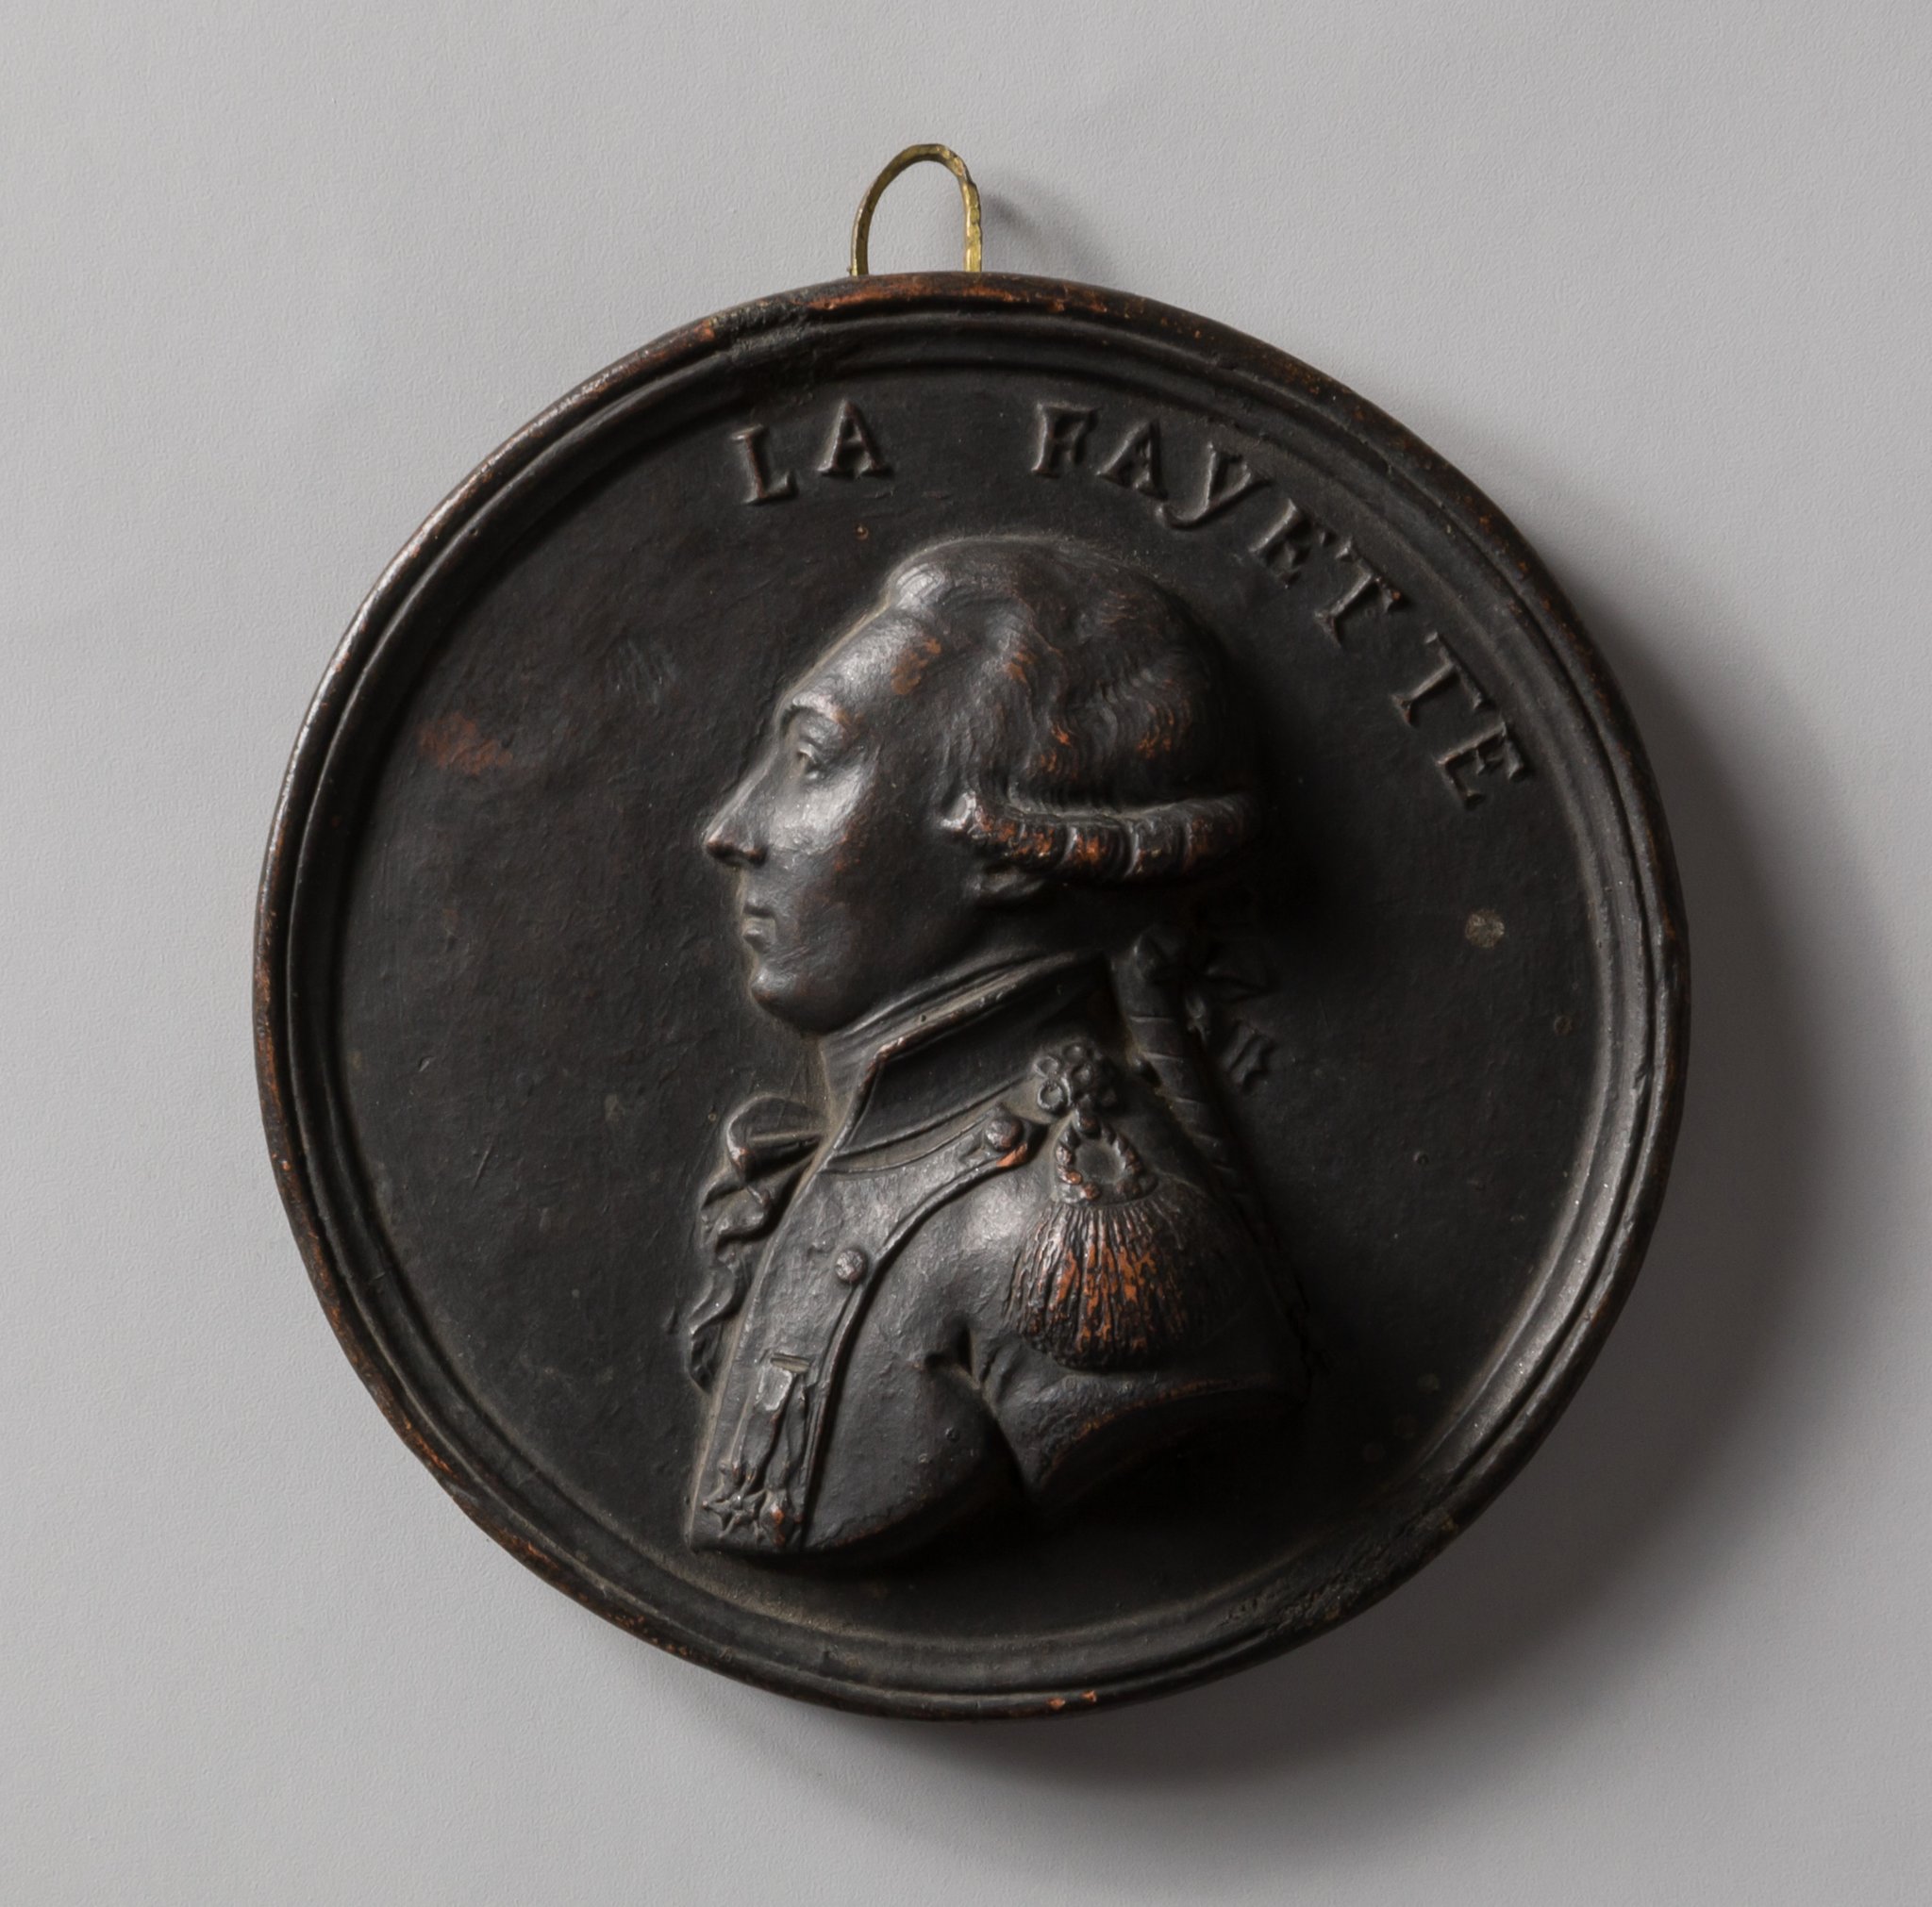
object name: medallion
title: Medallion of the Marquis de Lafayette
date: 1789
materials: terracotta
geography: france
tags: men,profiles,marquis de lafayette